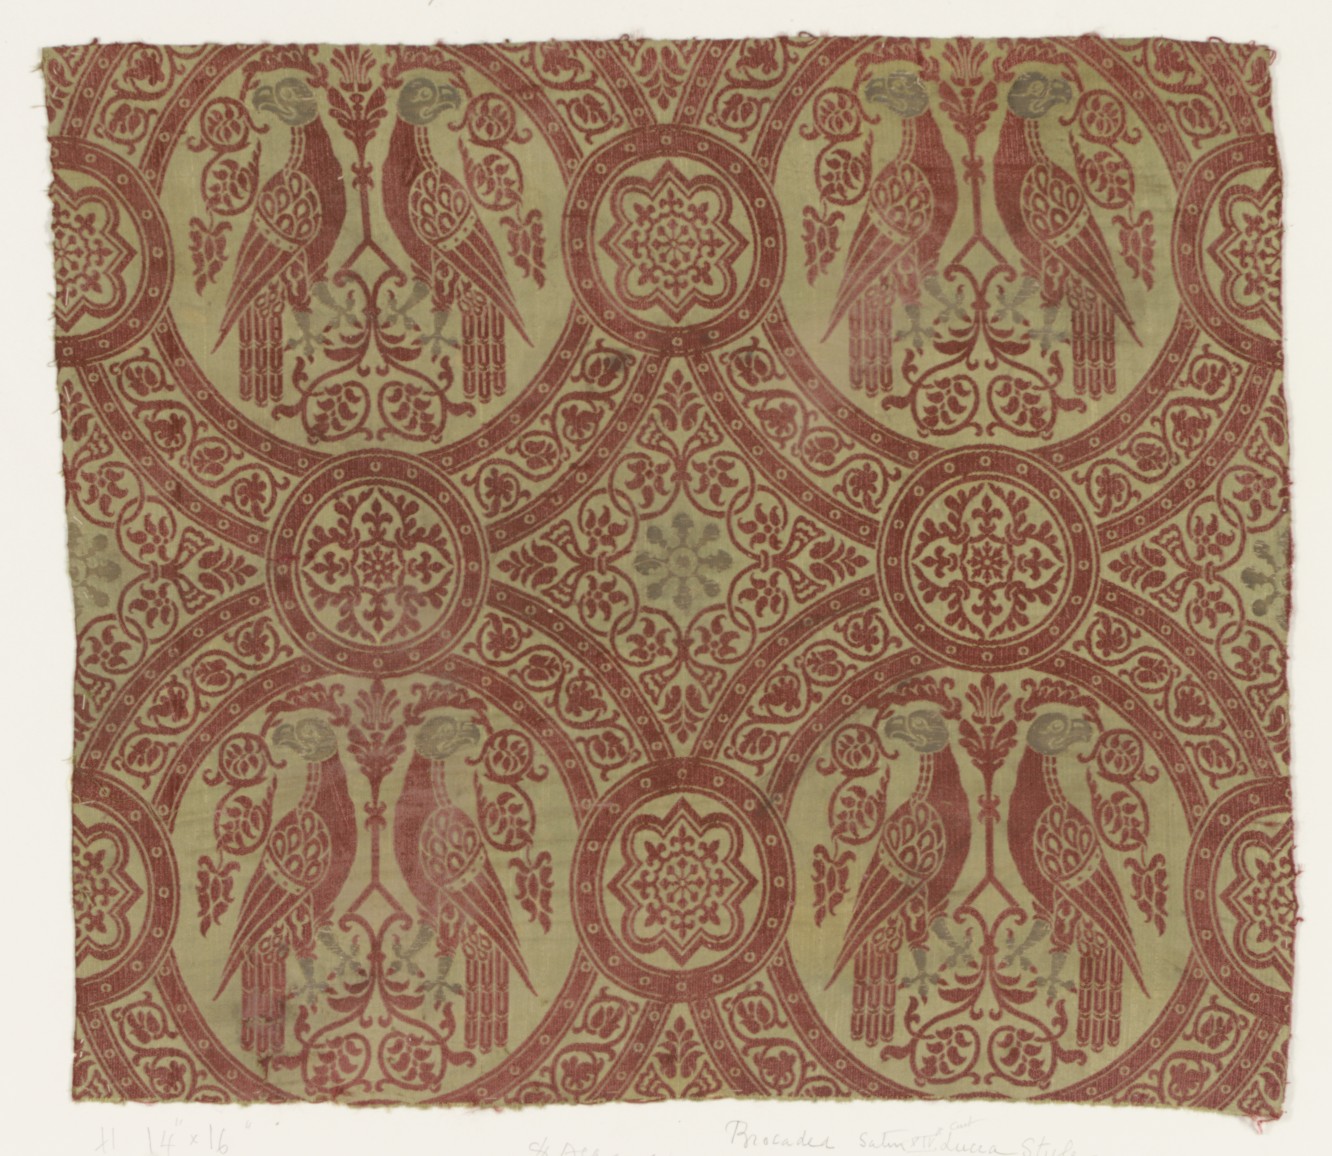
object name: fragment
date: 1301-1400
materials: metal thread, silk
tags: birds,flowers